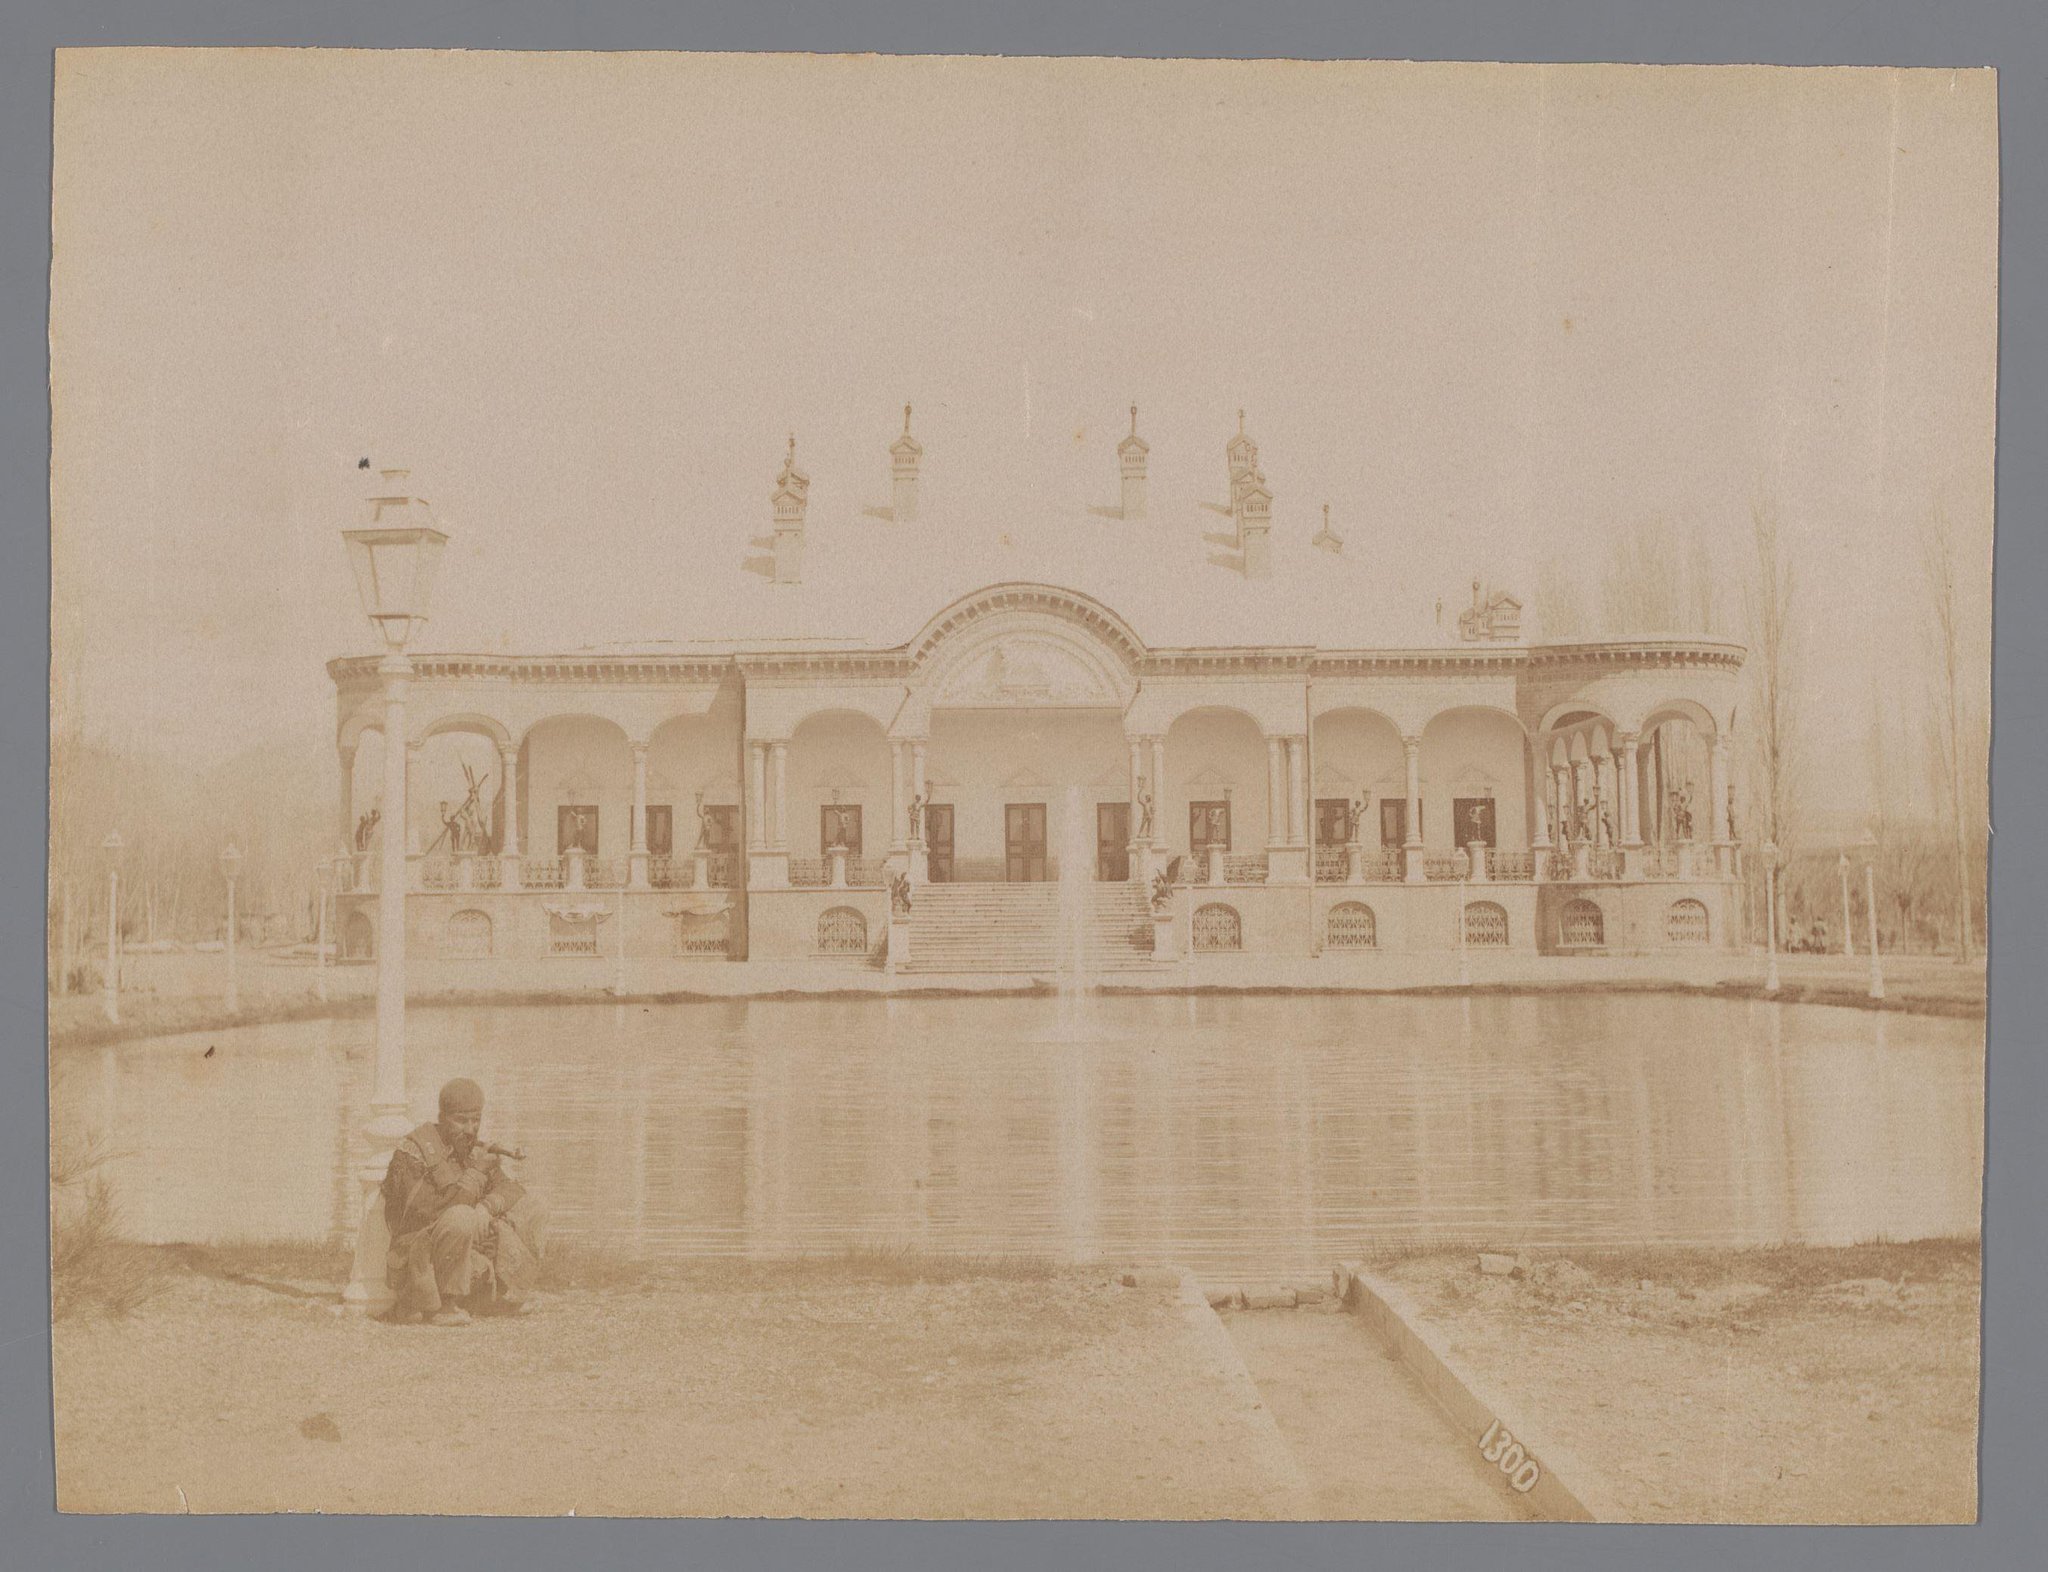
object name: photograph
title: Park in Teheran ["Parc de Sadrazan [?]"], Iran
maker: antoine sevruguin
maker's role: fotograaf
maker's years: 1840-1933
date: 1885-1910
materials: paper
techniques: albumen print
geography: iran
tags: teheran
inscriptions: number: ‘1300’, number: ‘15. [?]’, inscription: ‘Parc de Sadrazan [?]’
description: Park in Teheran ["Parc de Sadrazan [?]"]. Zicht op een wit gebouw met arcades en een veranda, waarlangs bronzen beelden op witte sokkels staan opgesteld. Daarvoor bevindt zich een vijver. Vooraan links poseert een man met pijp gehurkt tegen een lantaarnpaal voor de camera. Identificatie van plaats Teheran op grond van RP-F-00-6167 van hetzelfde park.